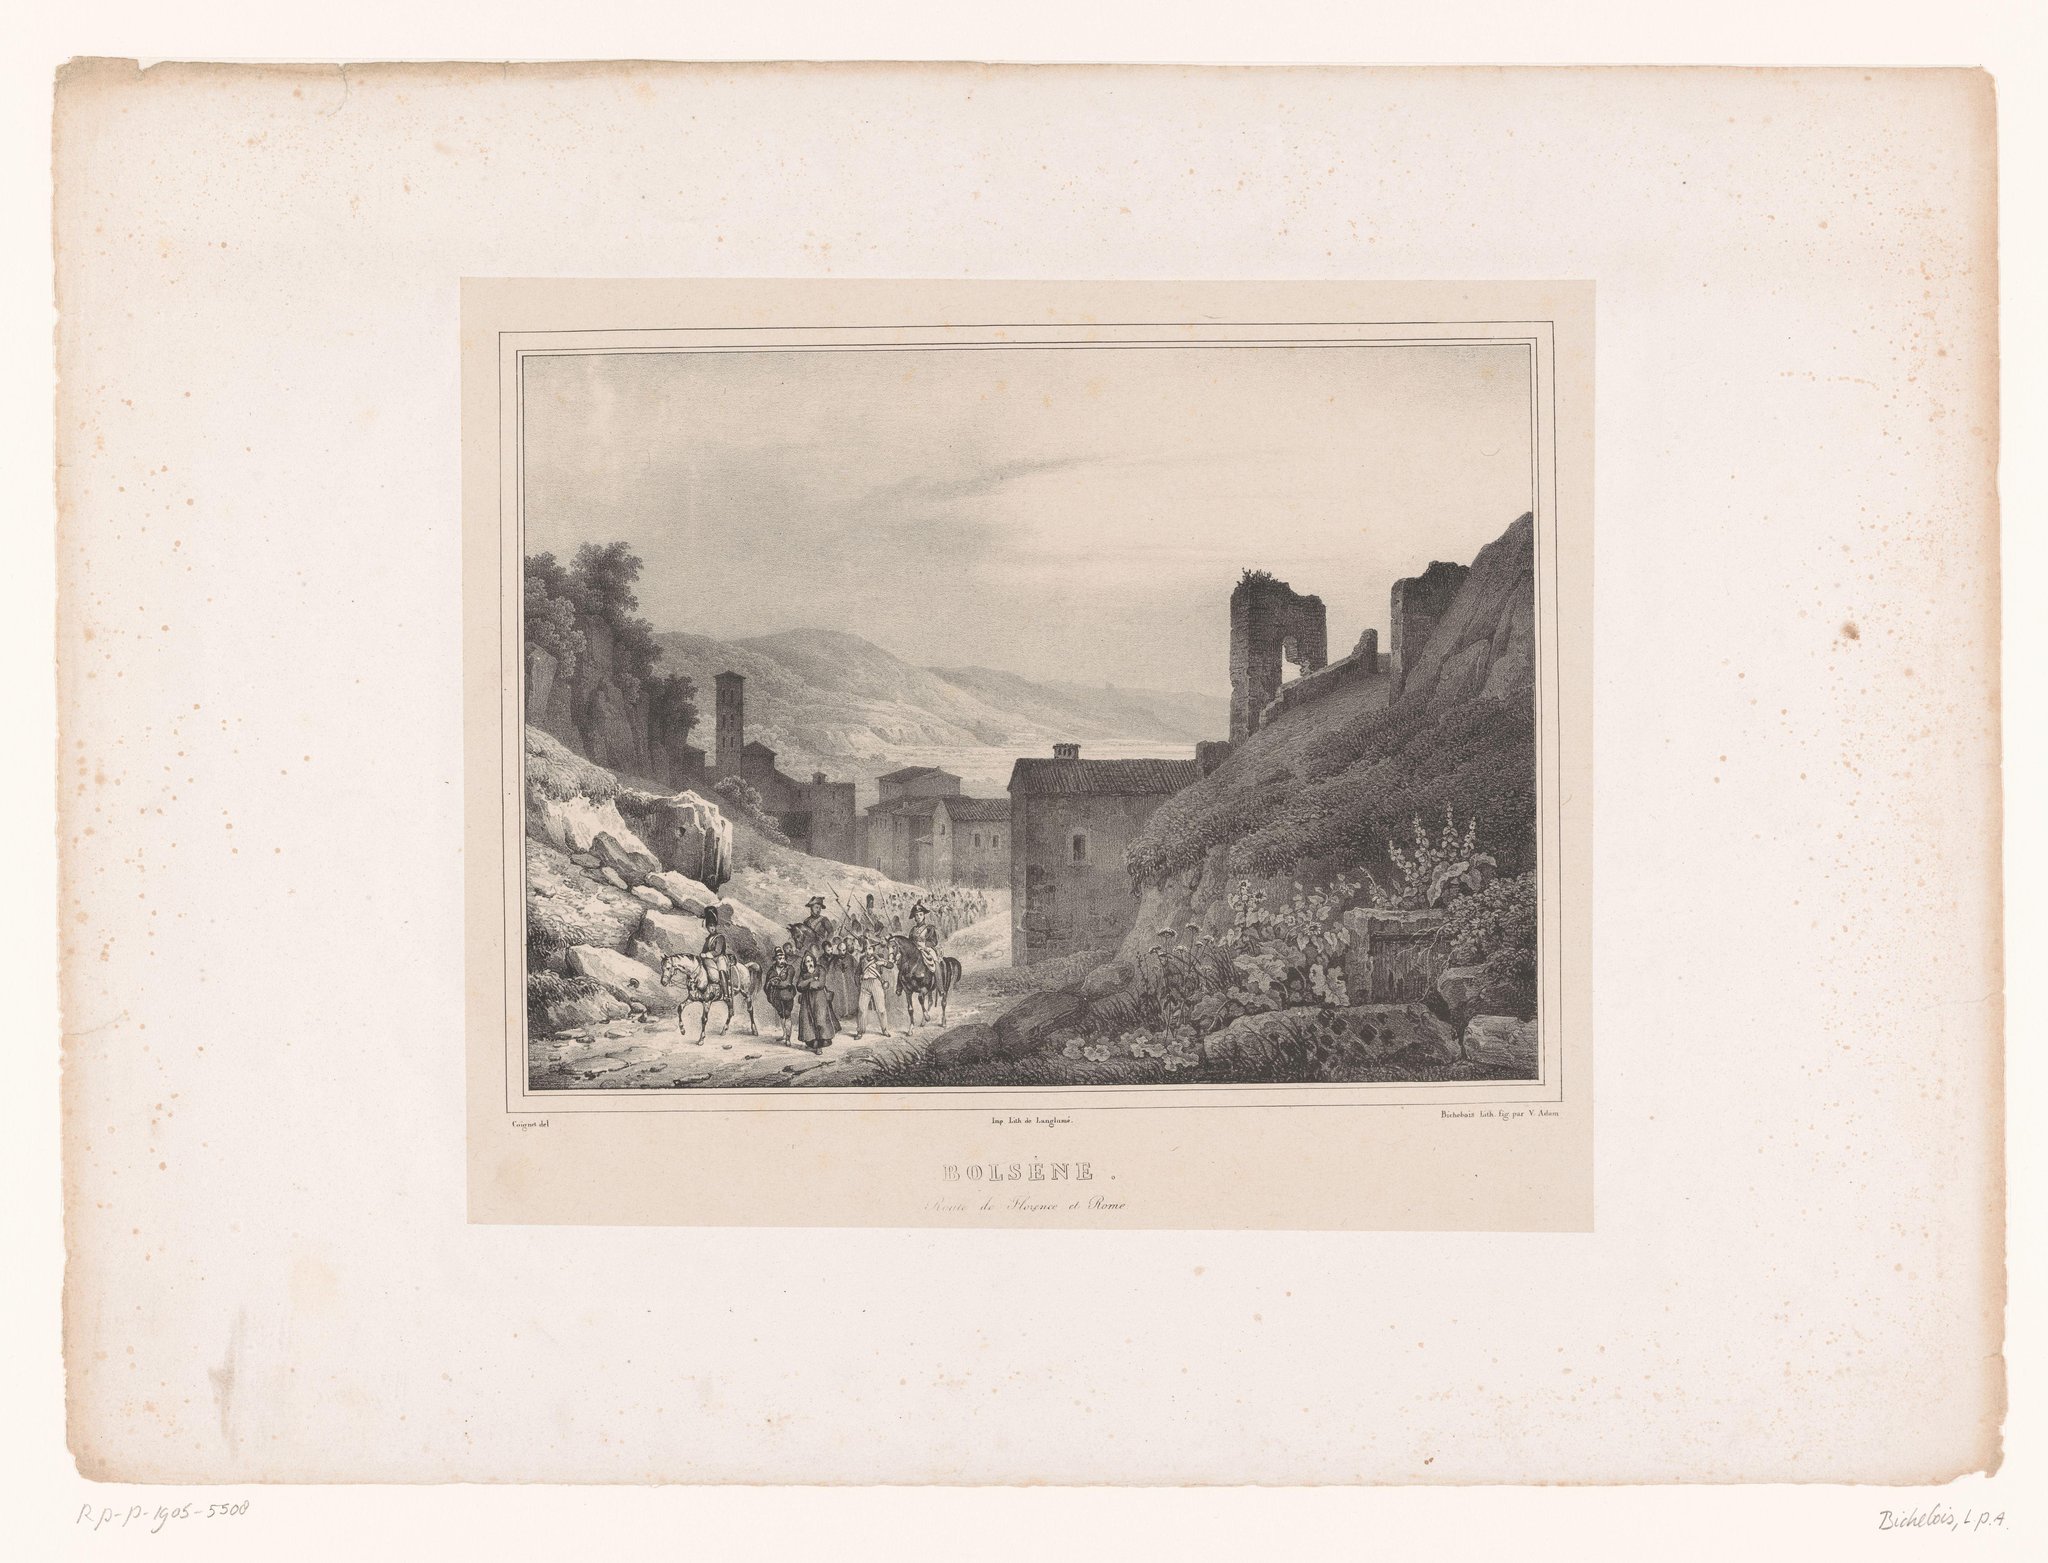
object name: print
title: Vues pittoresques de l'Italie dessinées d'après nature par M. Coignet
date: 1824-1826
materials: paper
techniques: lithograph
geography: paris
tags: army 'en route' (+ cavalry, horsemen), prospect of village, silhouette of village (+ city(-scape) with figures, staffage)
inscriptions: collector's mark: Lugt 2228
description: Een divisie van het Franse leger, inclusief cavalerie en geestelijken, trekt over de weg uit Bolsena.